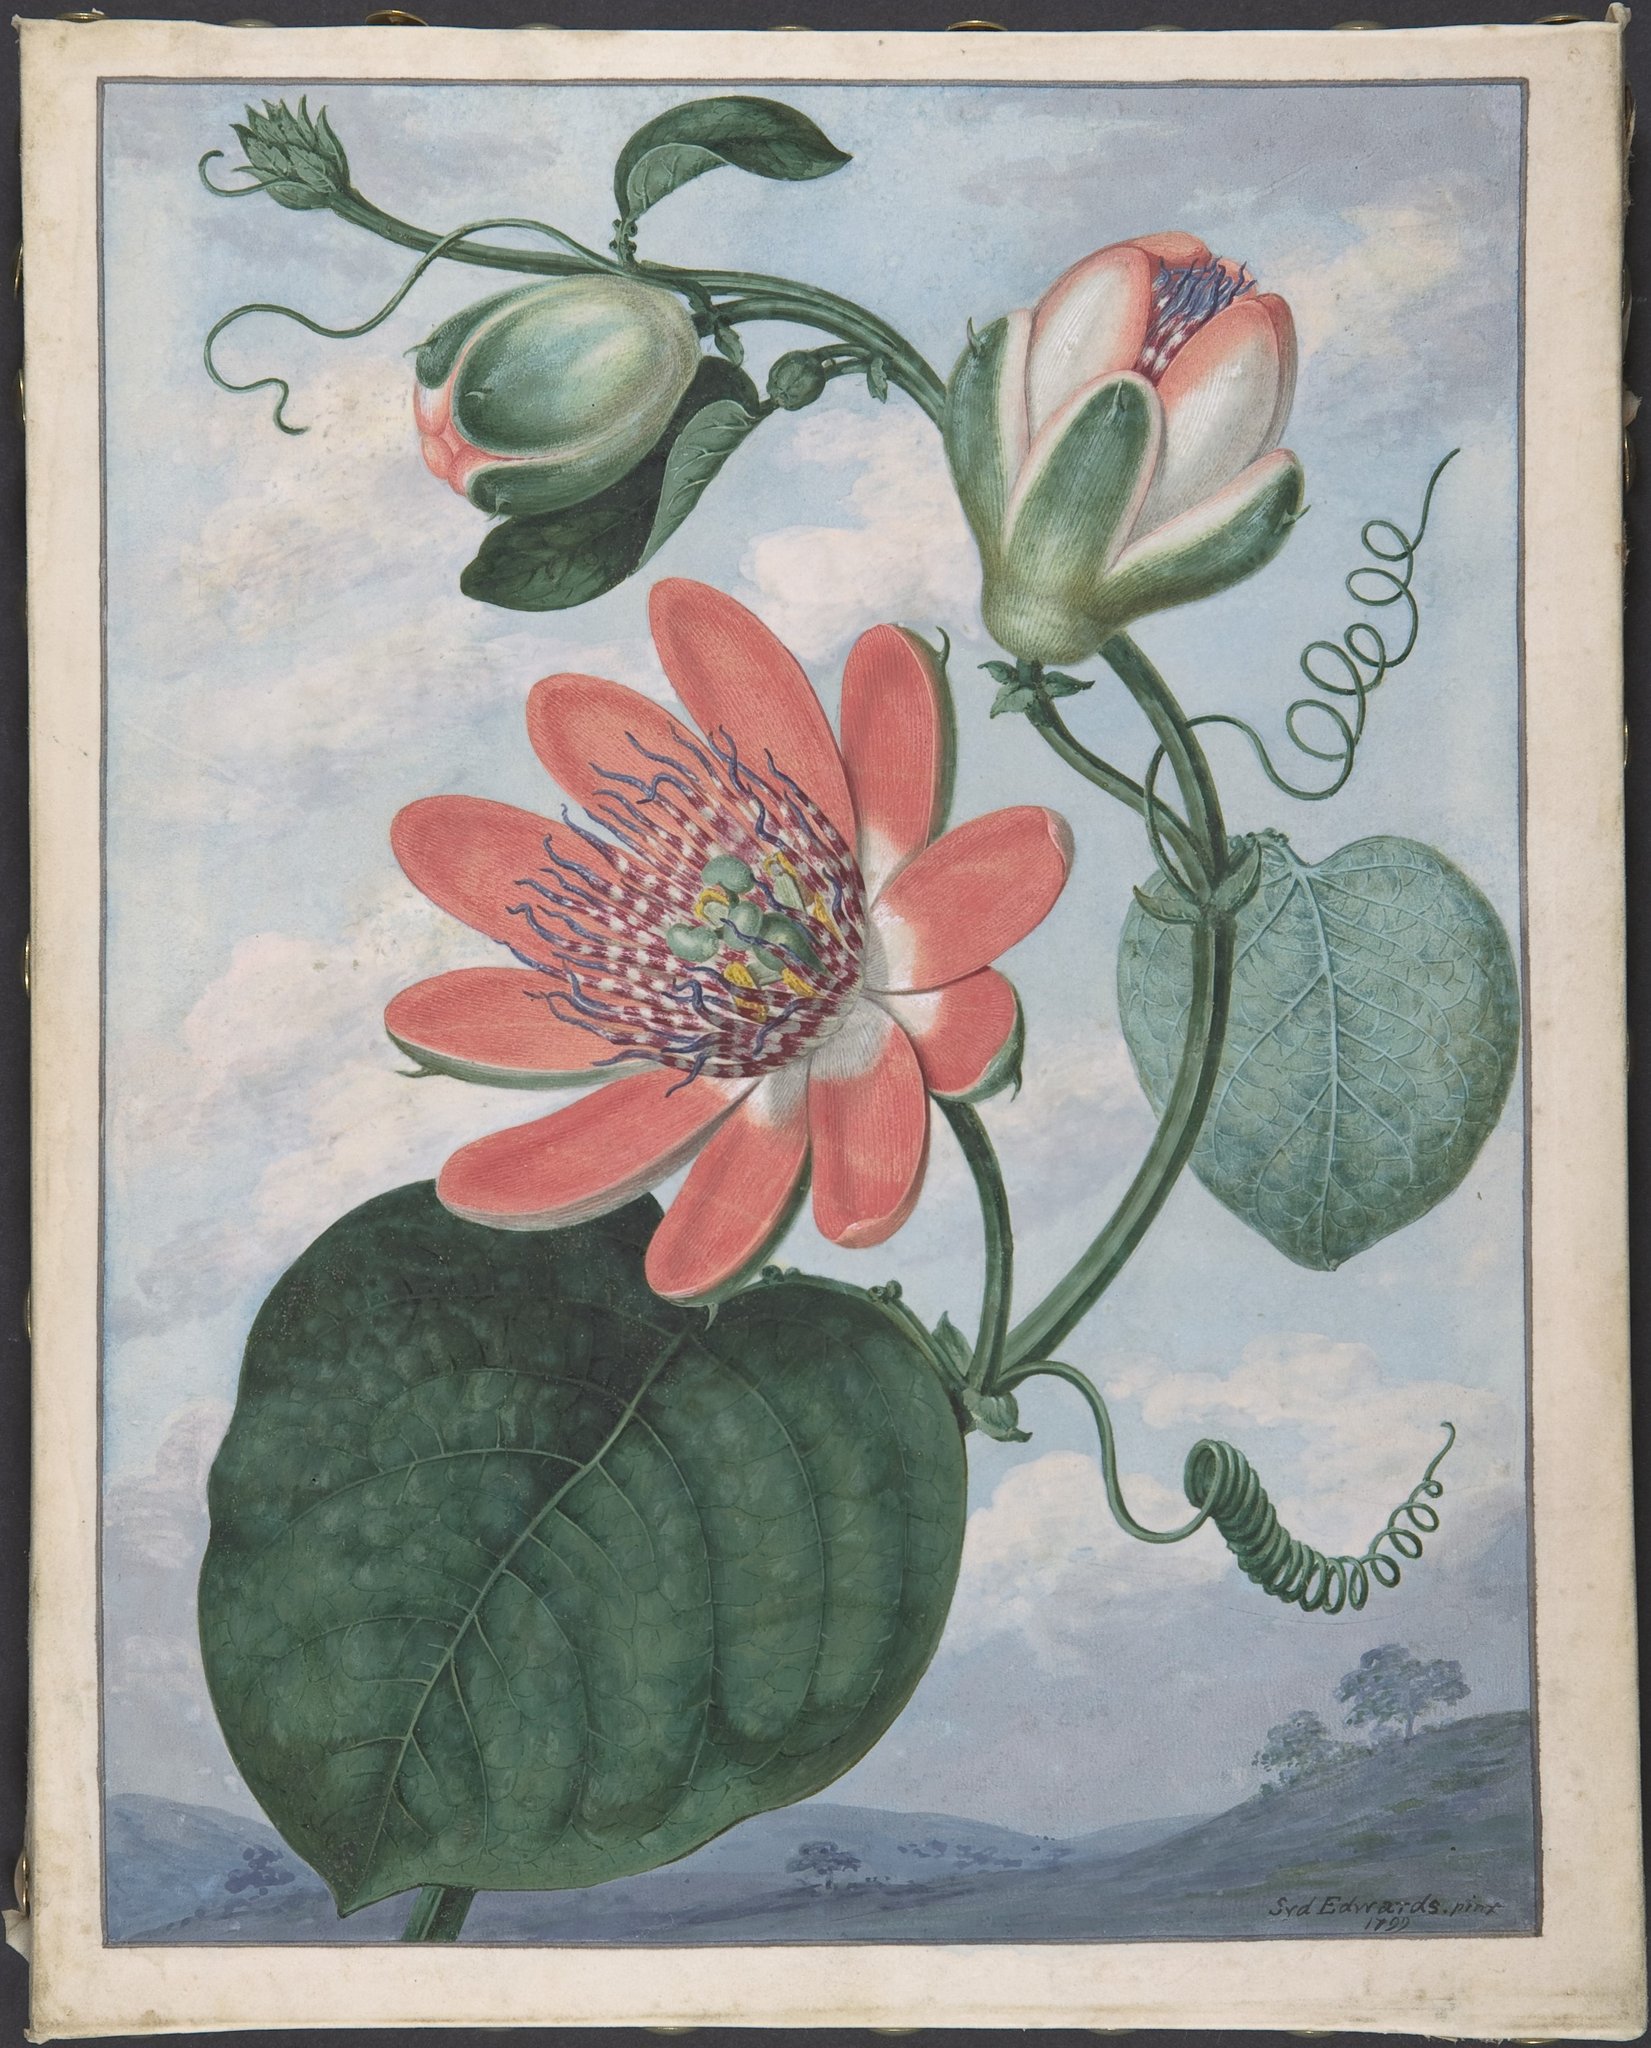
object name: drawing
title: Winged passionflower (Passiflora alata)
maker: sydenham teak edwards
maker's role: artist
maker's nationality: british, born wales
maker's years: 1768-1819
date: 1799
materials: paint, parchment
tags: flowers,leaves